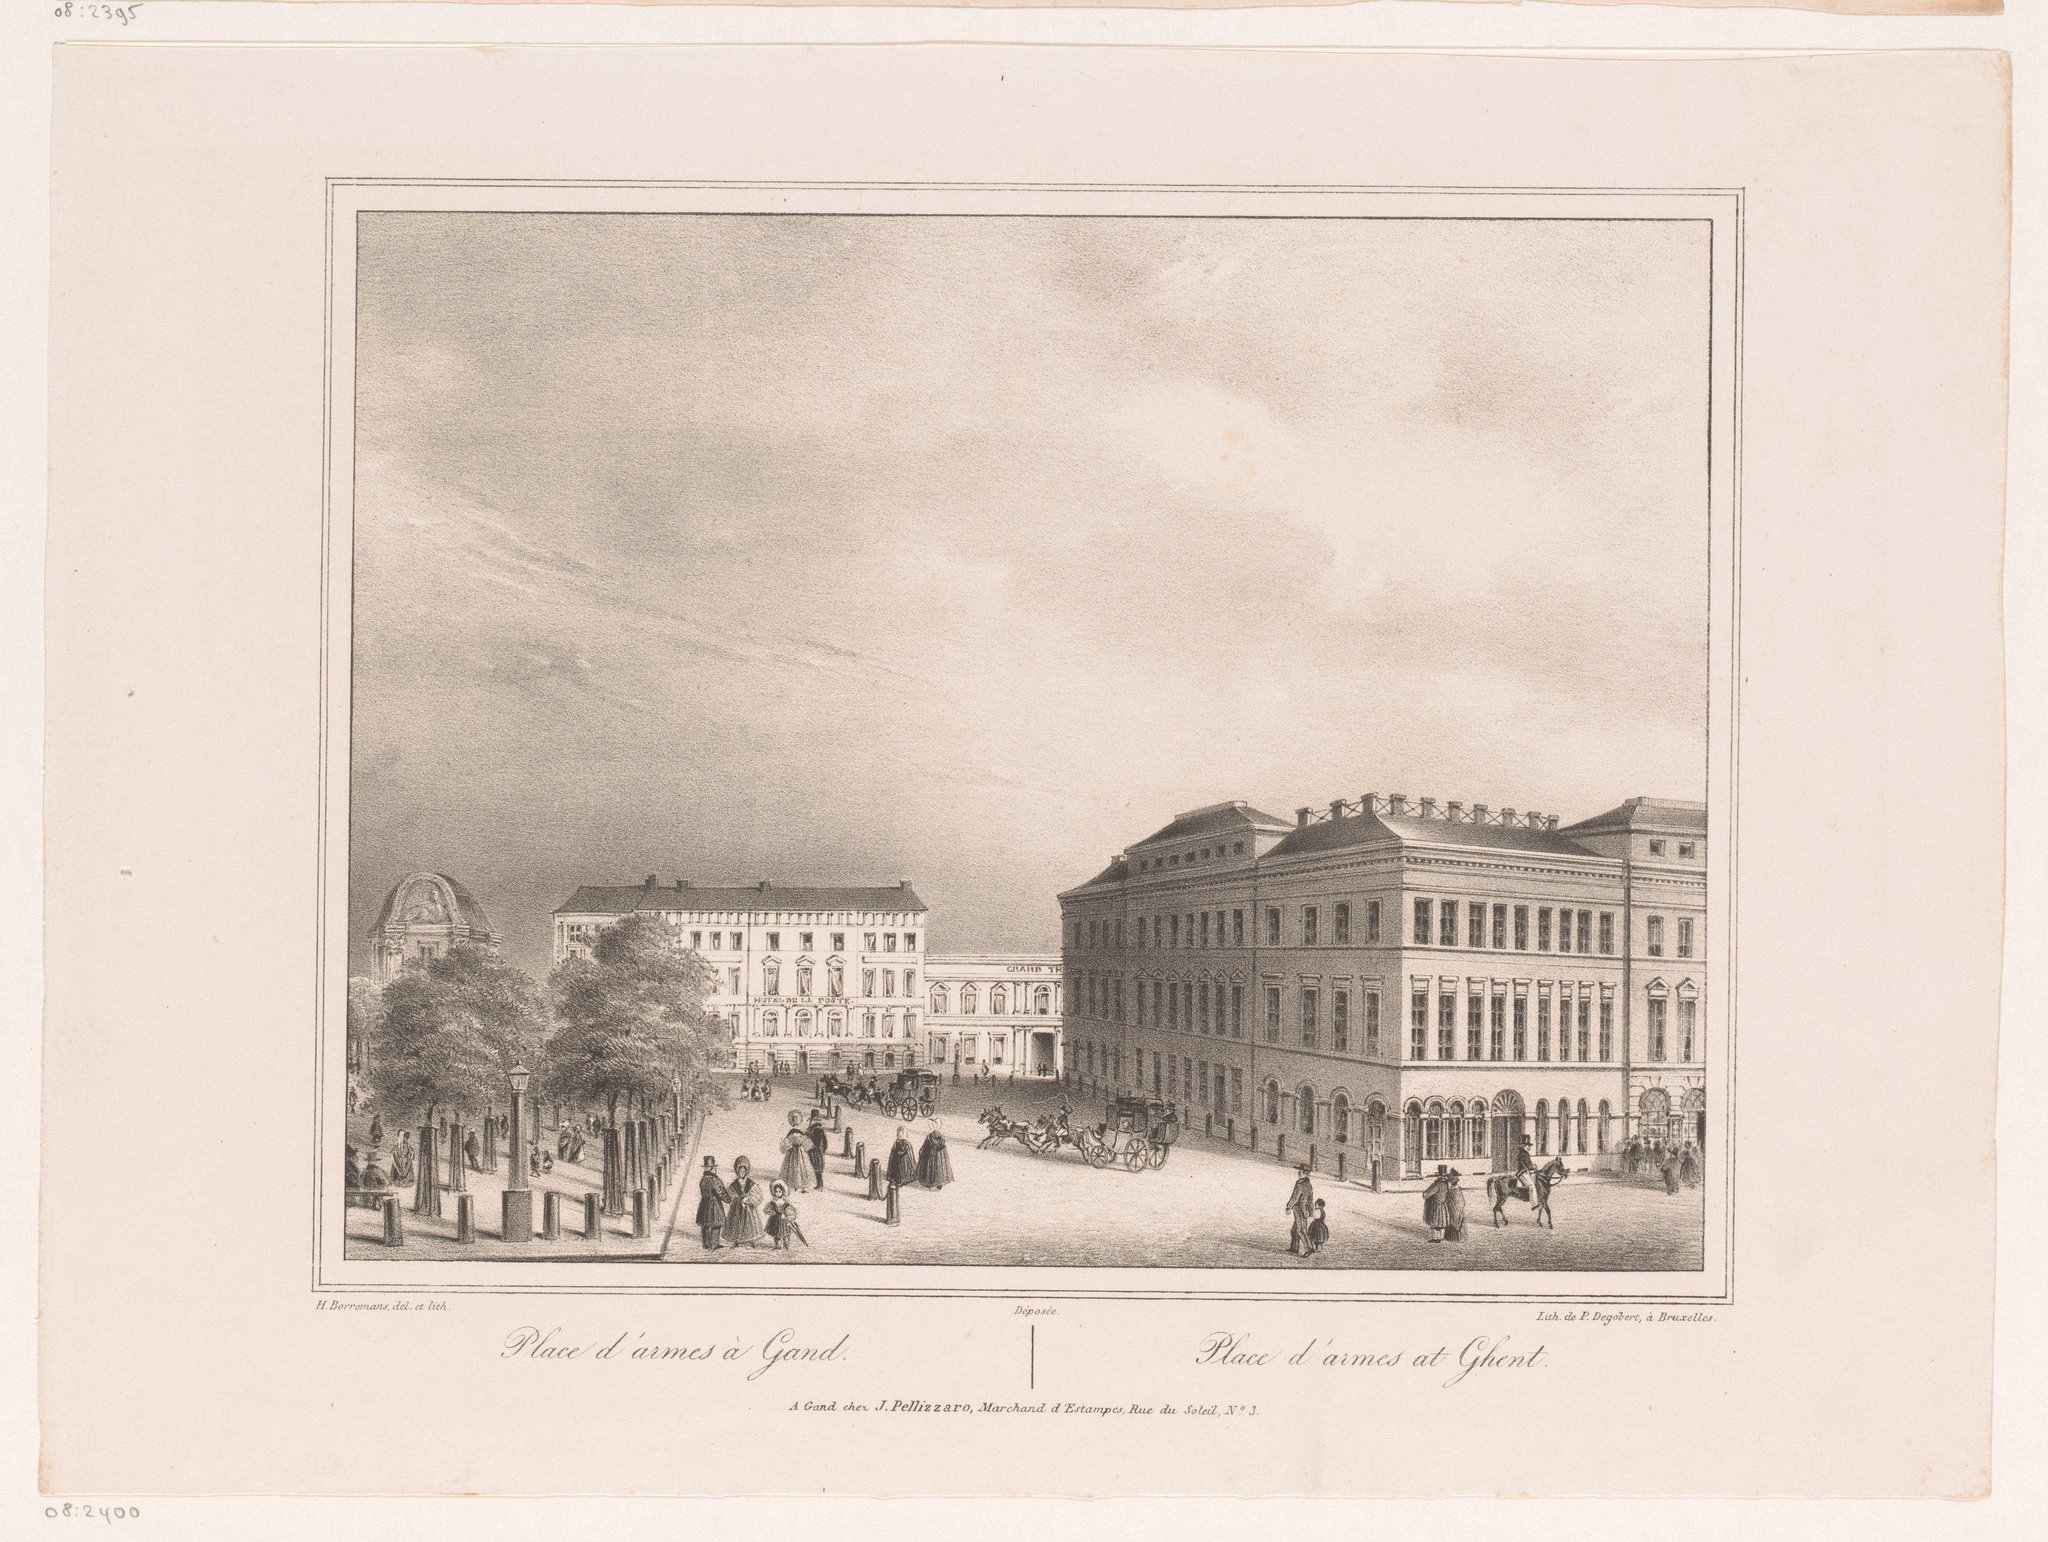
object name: print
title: Gezicht op de Kouter te Gent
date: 1822-1844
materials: paper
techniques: lithograph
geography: brussels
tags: village square, place, ghent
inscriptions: : ‘Déposé’, collector's mark: Lugt 2228